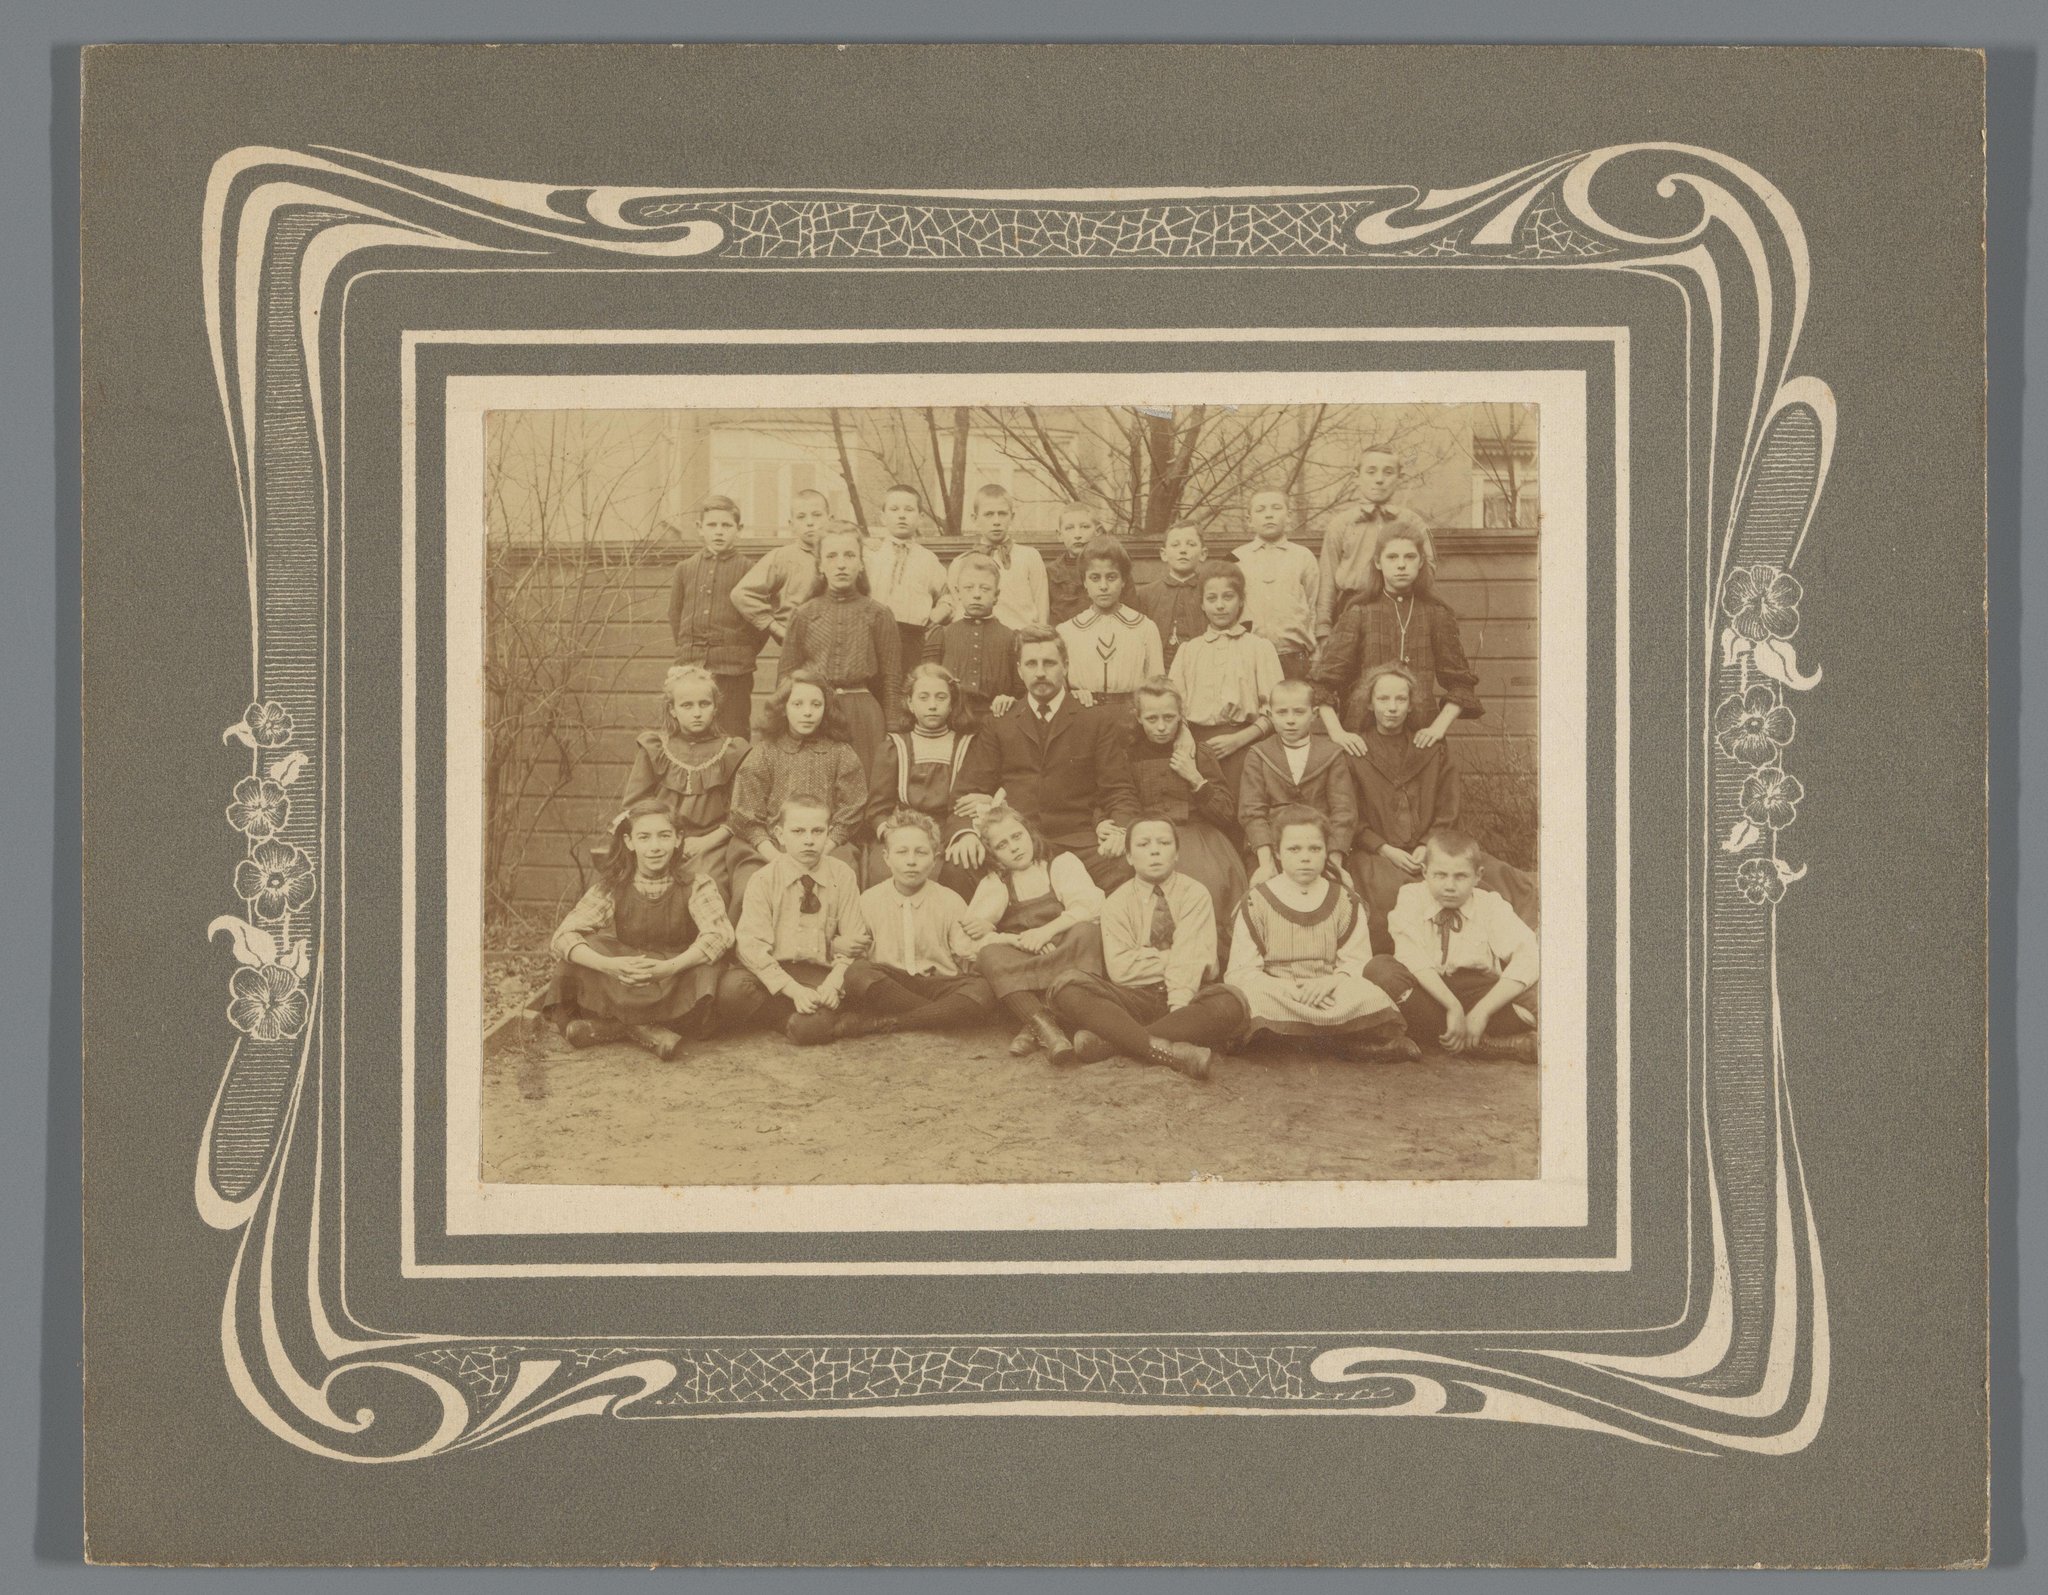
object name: photograph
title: Groepsportret van een onbekende schoolklas met jongens en meisjes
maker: Anonymous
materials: paper, cardboard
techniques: gelatin silver print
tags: elementary school; class, form, anonymous historical persons portrayed in a group, in a group-portrait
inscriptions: inscription: ‘23 Dec '09’